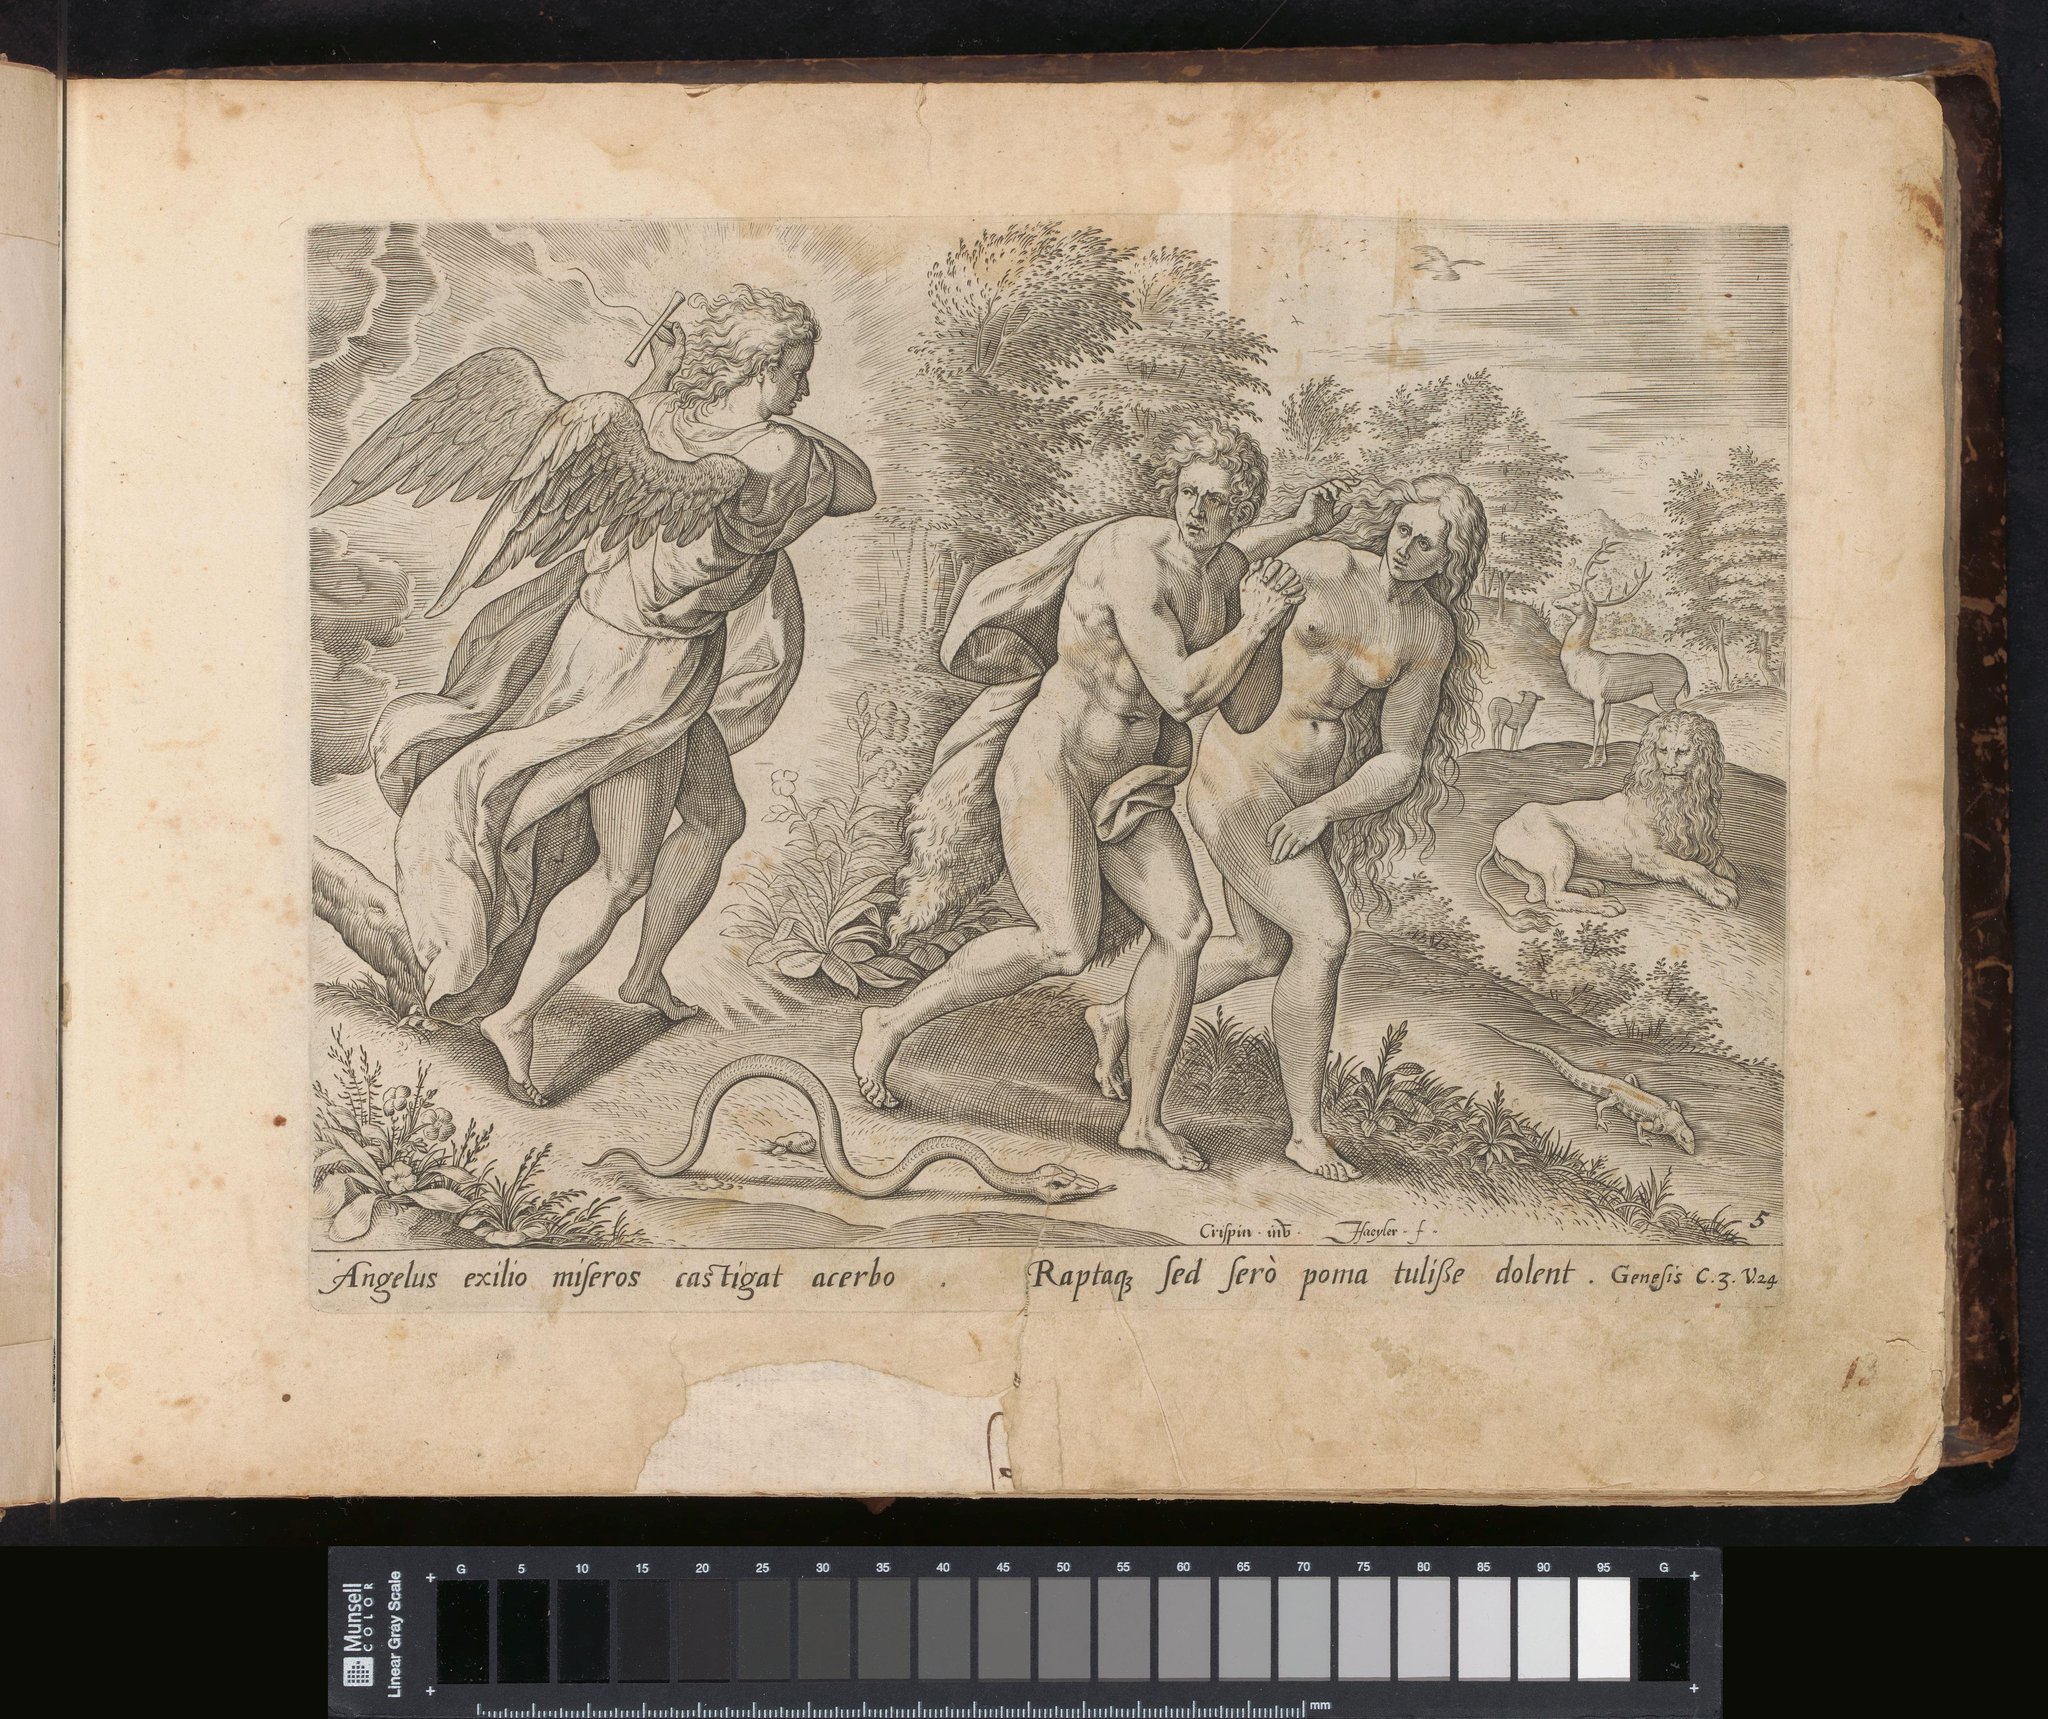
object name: print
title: Expulsion from Paradise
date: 1643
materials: paper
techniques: engraving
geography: amsterdam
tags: snakes, an angel chases adam and eve out of paradise with a (flaming) sword, beasts of prey, predatory animals: lion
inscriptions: number: ‘13’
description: Adam en Eva worden door een engel met een vlammend zwaard uit het paradijs verdreven. Naast hen kruipt de slang. Rechts op de achtergrond een leeuw en een hert. Onderaan een verwijzing naar de Bijbeltekst in het Latijn. Deze prent maakt deel uit van een album.